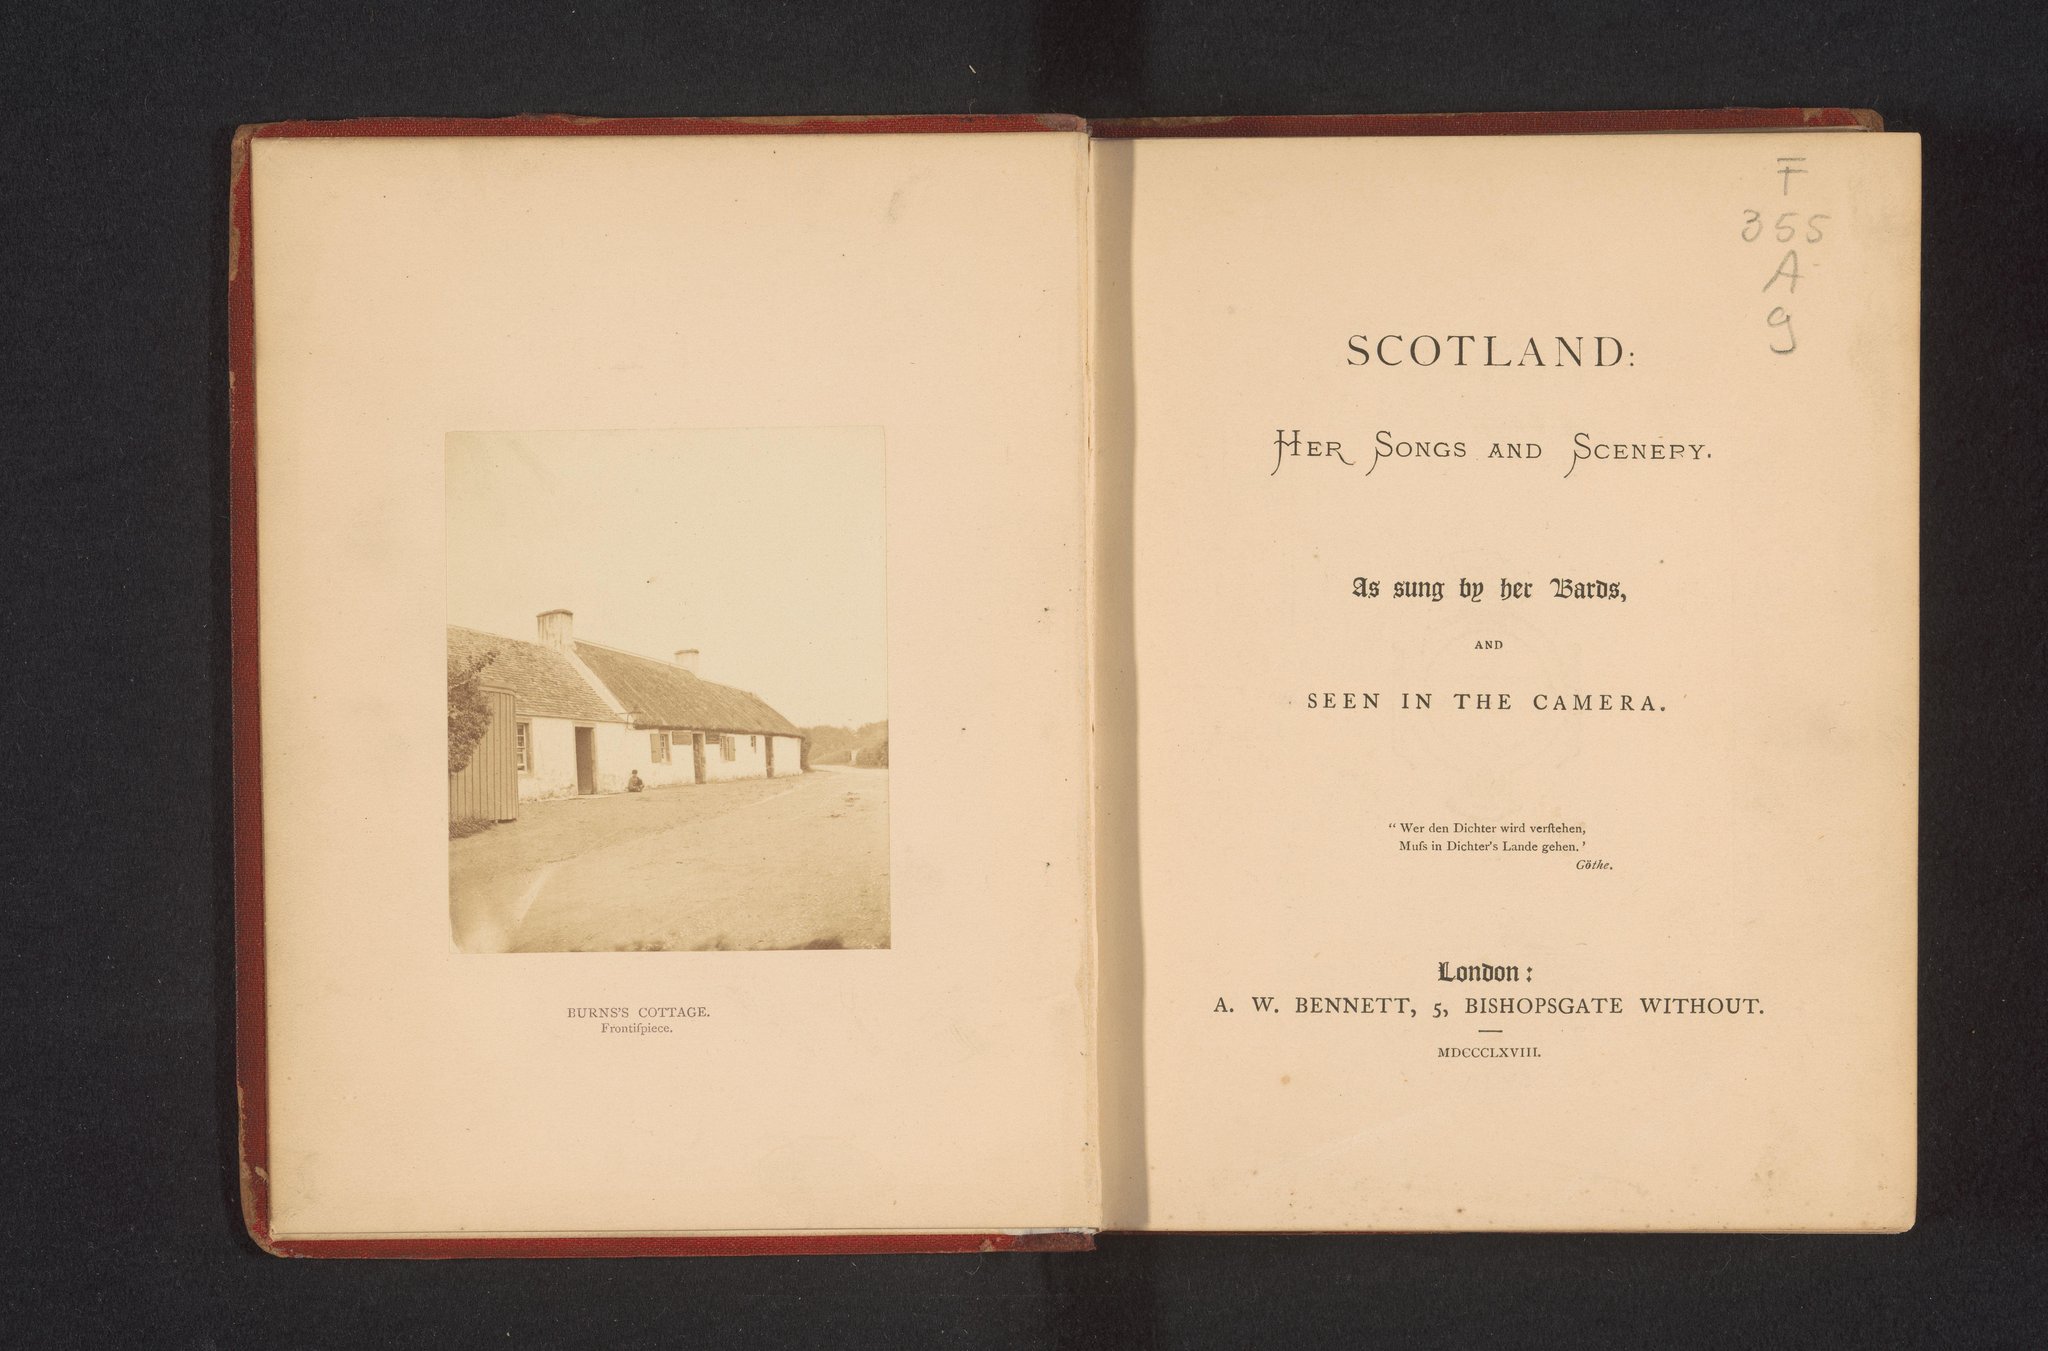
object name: page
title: Burns's cottage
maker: stephen thompson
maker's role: fotograaf, schrijver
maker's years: 1831-1893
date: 1863-1868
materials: photographic support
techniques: albumen print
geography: alloway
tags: rural housing, e.g. country-house, villa, cottage, façade (of house or building)